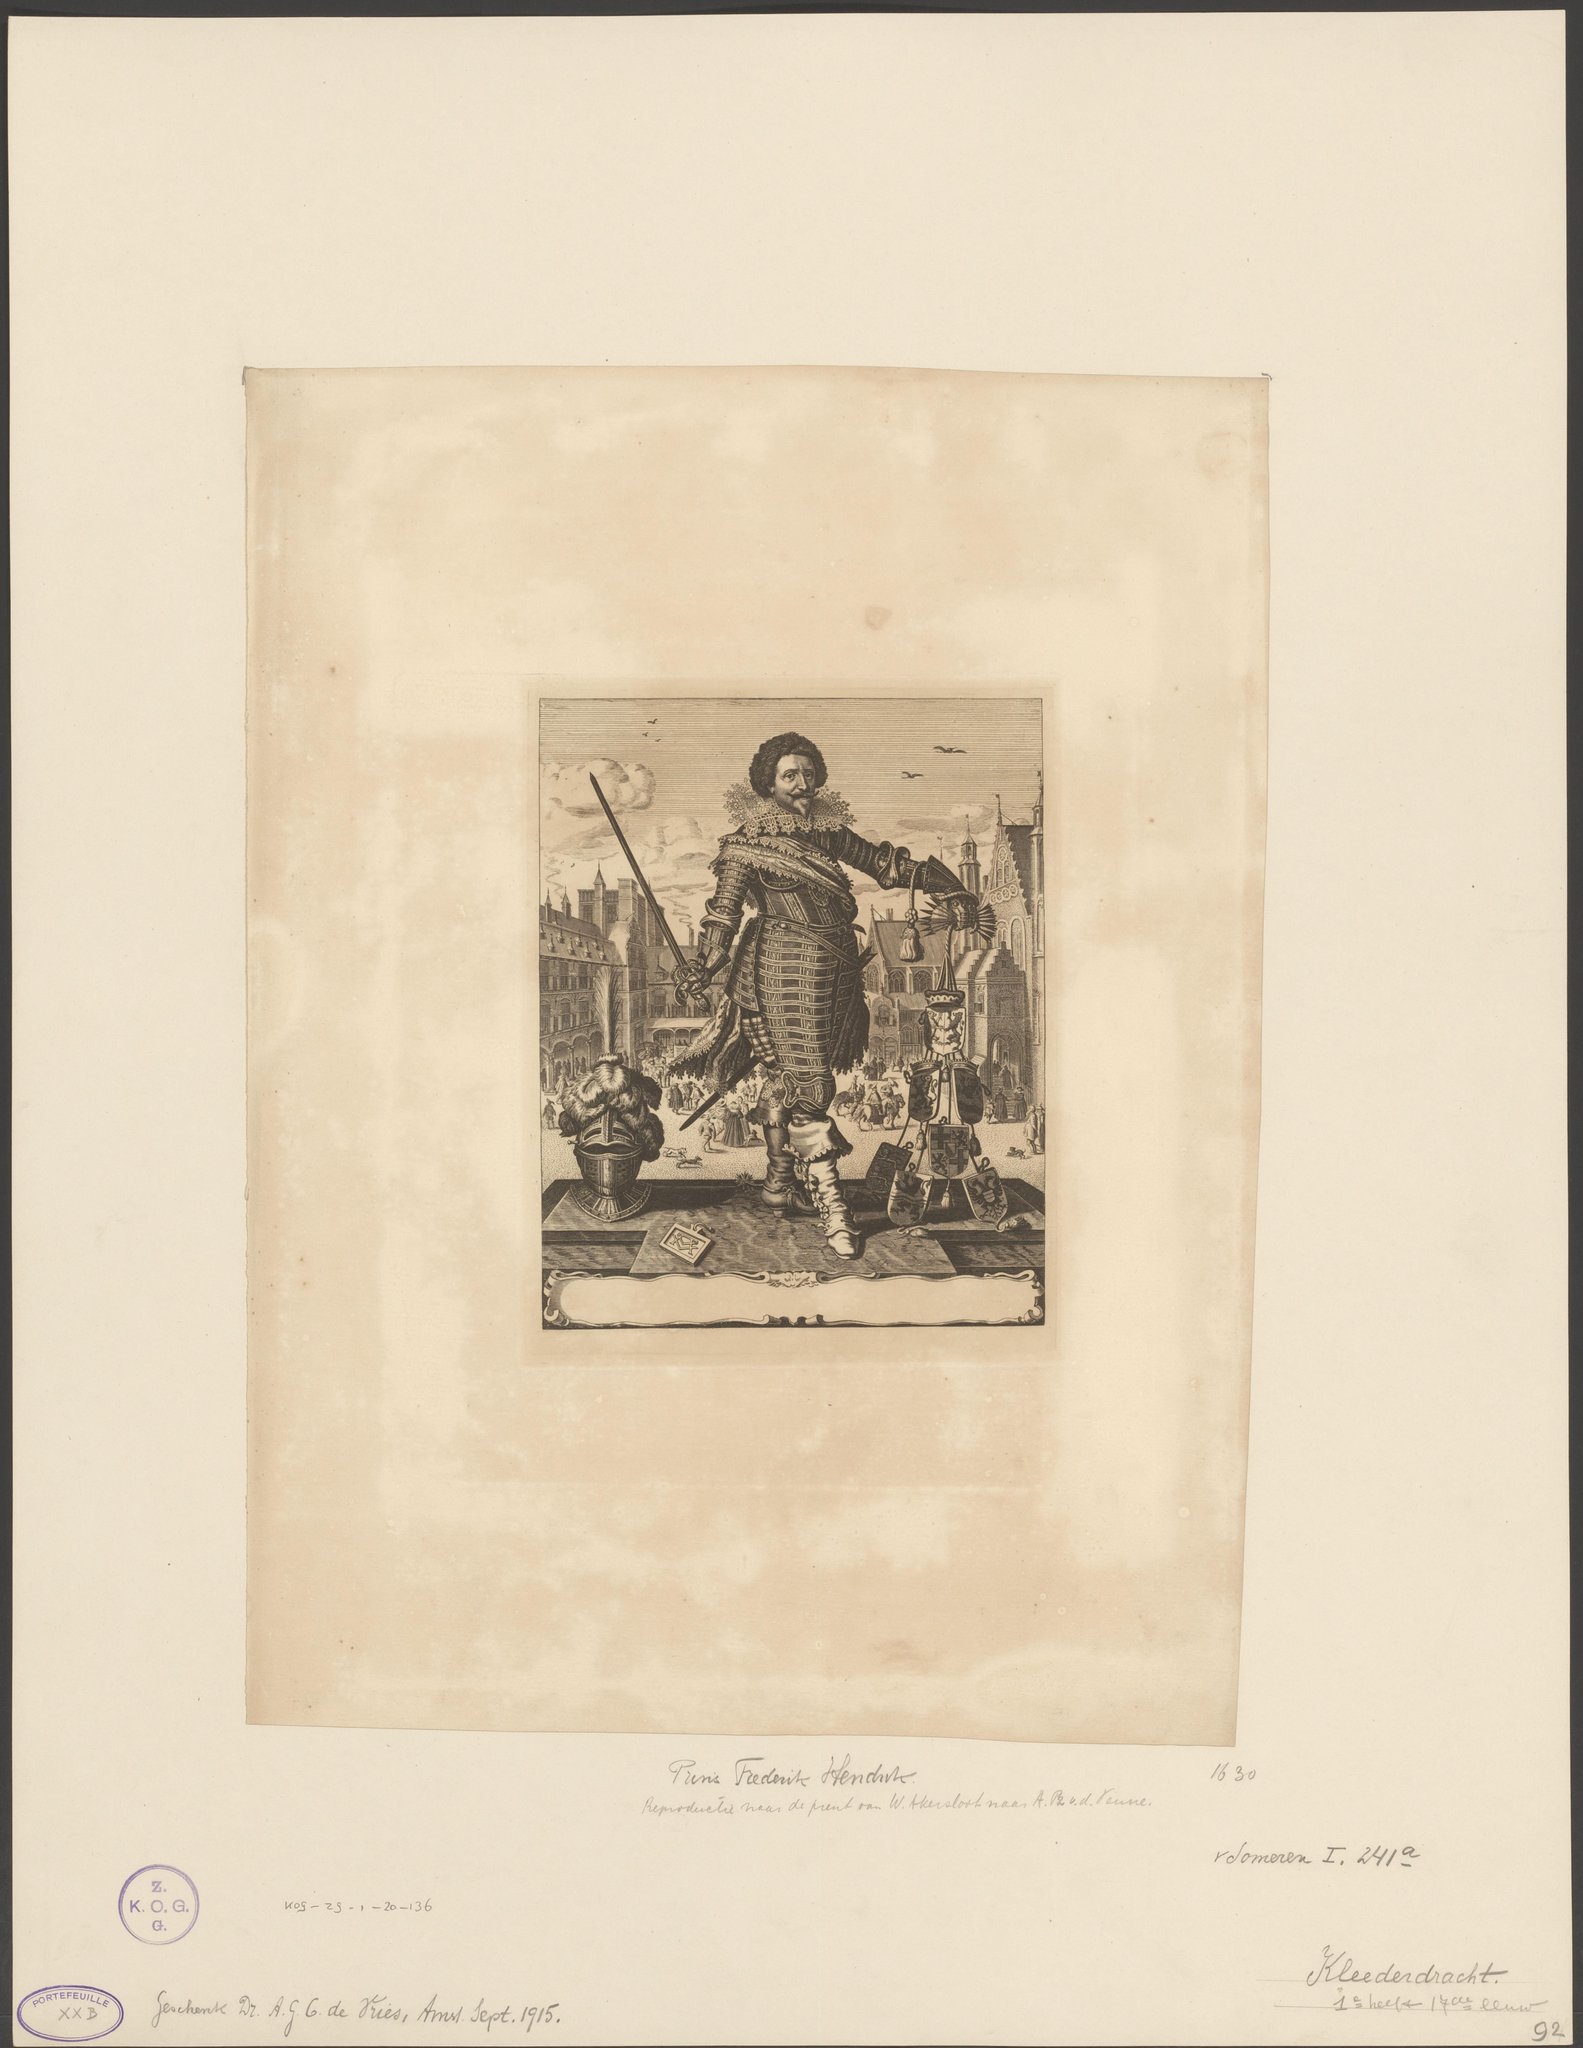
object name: print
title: Portret van Frederik Hendrik, prins van Oranje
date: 1628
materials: paper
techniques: engraving, etching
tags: delft, frederick henry (prince of orange), historical persons, the hague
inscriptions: collector's mark: Lugt 1641, stamp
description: Portret van Frederik Hendrik, ten voeten uit in wapenrusting, staande op een bordes. In zijn rechterhand een degen, in zijn linker een bundel pijlen en een touw. Aan het touw zijn de wapens van de Zeven Provinciën vastgemaakt. Op de achtergrond het bevolkte Binnenhof te Den Haag. Onderwerpsrubrieken binnen de Atlas Zeden en Gewoonten: Zeden en Gewoonten in Engeren Zin, De Kleeding, Kleederdrachten (tijdvakken), Het begin der 17de eeuw. (De Fransche mode).